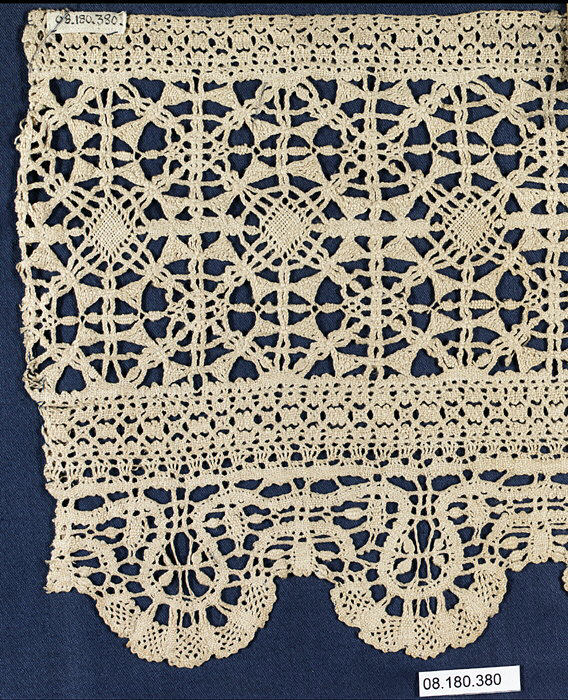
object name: piece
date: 1701-1800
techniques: lace